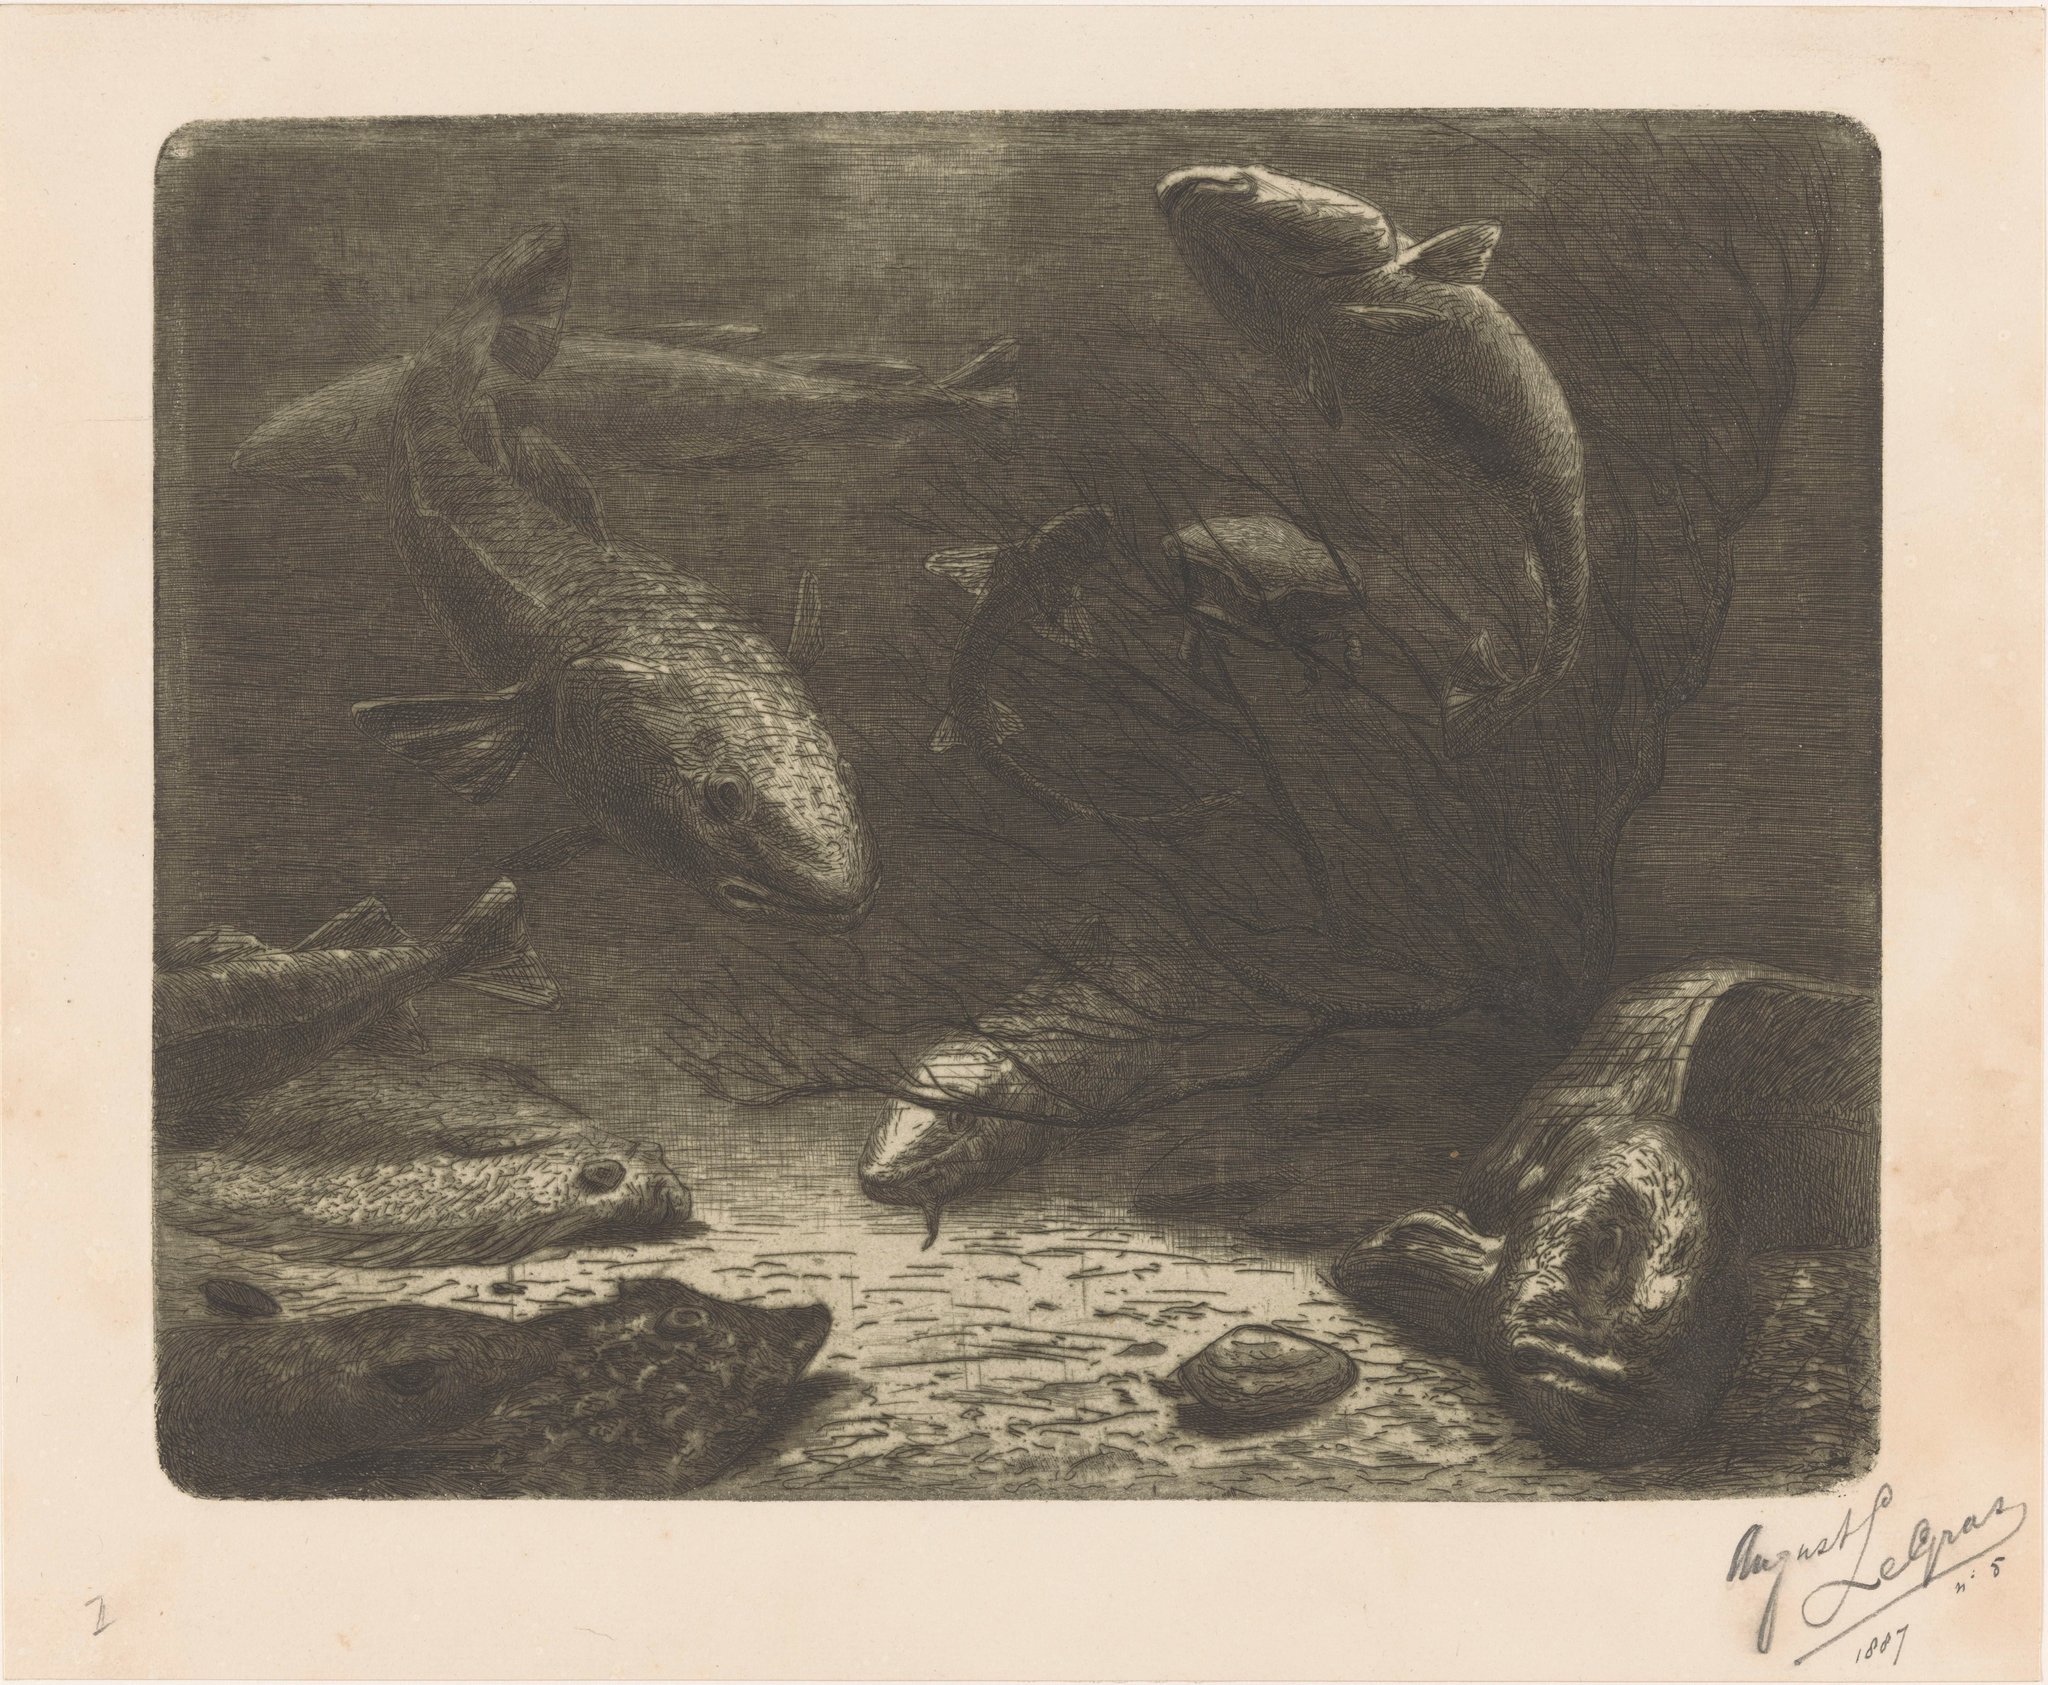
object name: print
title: Aquarium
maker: august le gras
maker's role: draughtsman, print maker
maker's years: 1864-1915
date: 1887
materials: paper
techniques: drypoint, etching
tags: aquarium, crustaceans: crab, bony fishes: plaice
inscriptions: collector's mark: Lugt 2233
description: Aquarium met elf vissen en een krab. Links liggen twee schollen op de bodem. Rechts een waterplant.